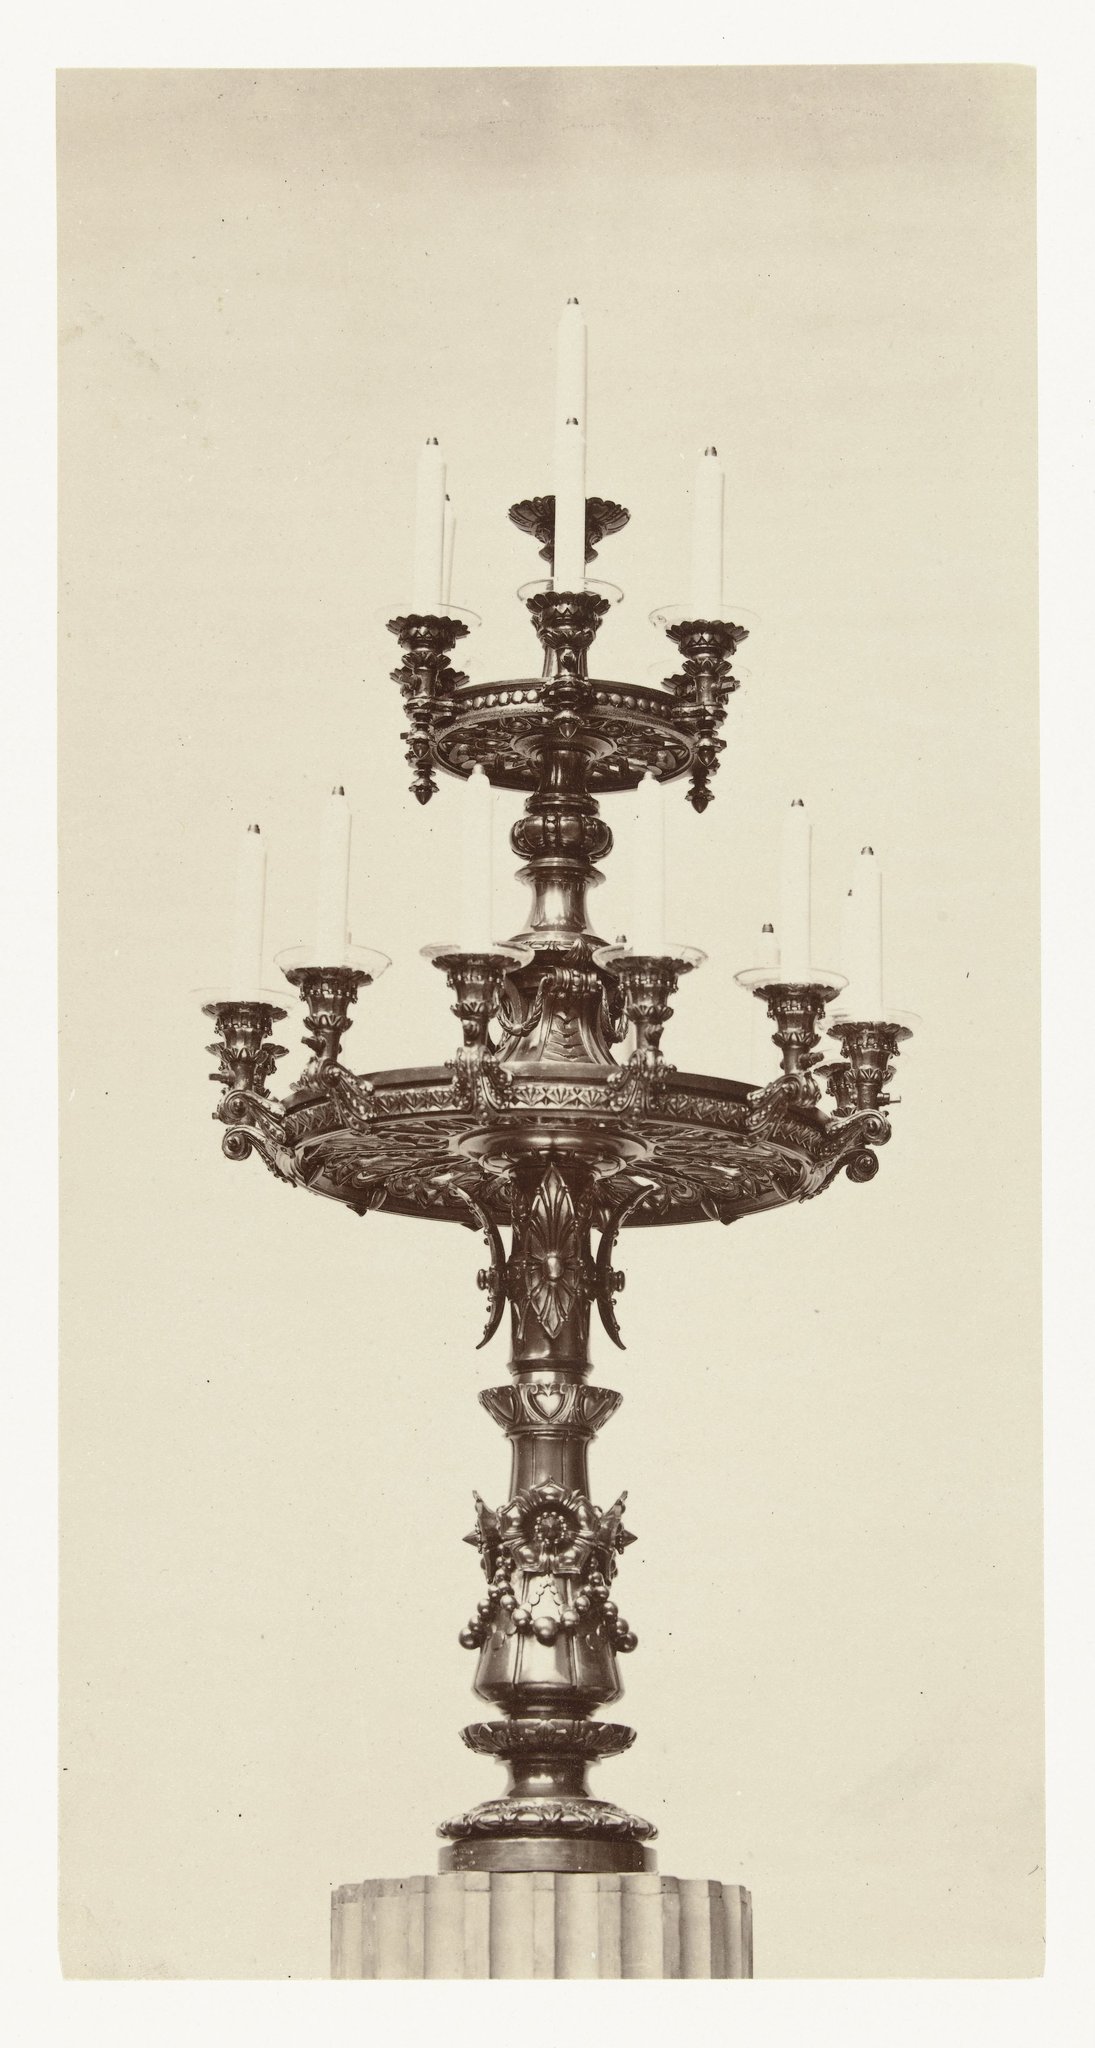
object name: photograph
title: 14. Le nouvel Opéra de Paris. Bronzes.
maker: louis-emile durandelle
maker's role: fotograaf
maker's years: 1839-1917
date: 1878-1881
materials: photographic support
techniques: albumen print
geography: paris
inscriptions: number: ‘14’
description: bij boek in Bibliotheek RMA, Zie Frizot, pp. 217-223, vgl G. Vicaire, Manuel de l'amateur de livres du XIXe siècle, vol. 3, column 870.